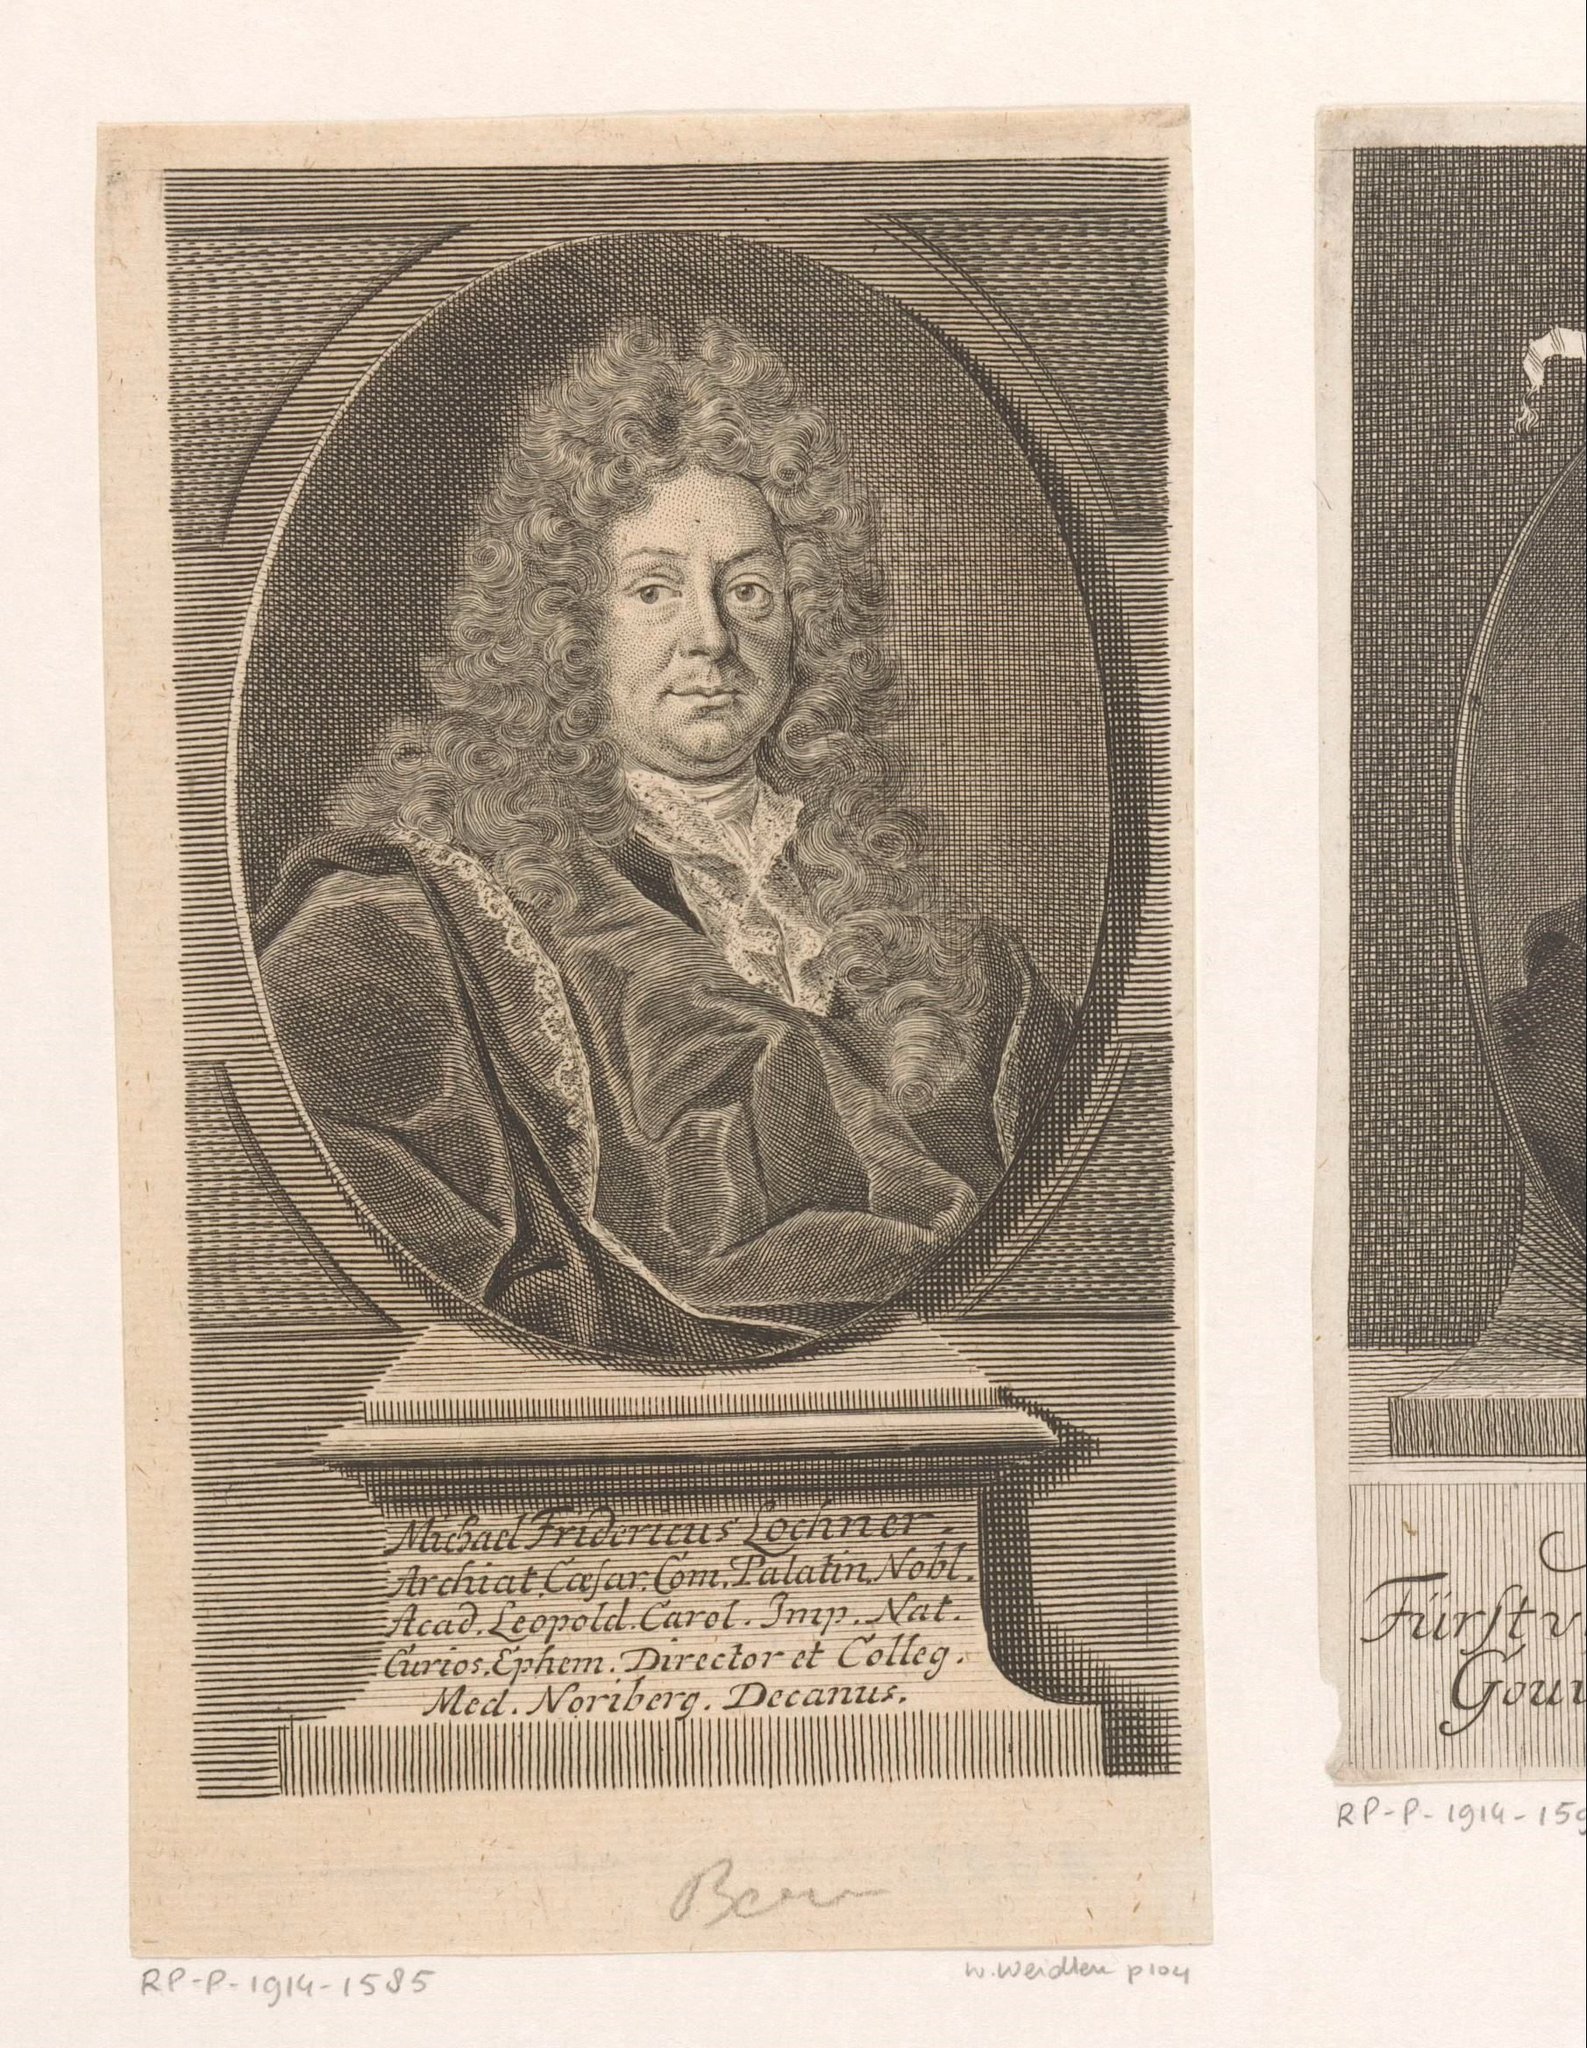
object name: print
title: Portret van Michael Friedrich Lochner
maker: martin bernigeroth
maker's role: print maker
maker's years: 1670-1733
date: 1714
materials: paper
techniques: engraving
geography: leipzig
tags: historical persons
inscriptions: collector's mark: Lugt 2228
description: Prent ook gebruikt in: Deutsche Acta Eruditorum (...). dl. 24. Leipzig: Johann Gottlieb Gleditsch, 1714.